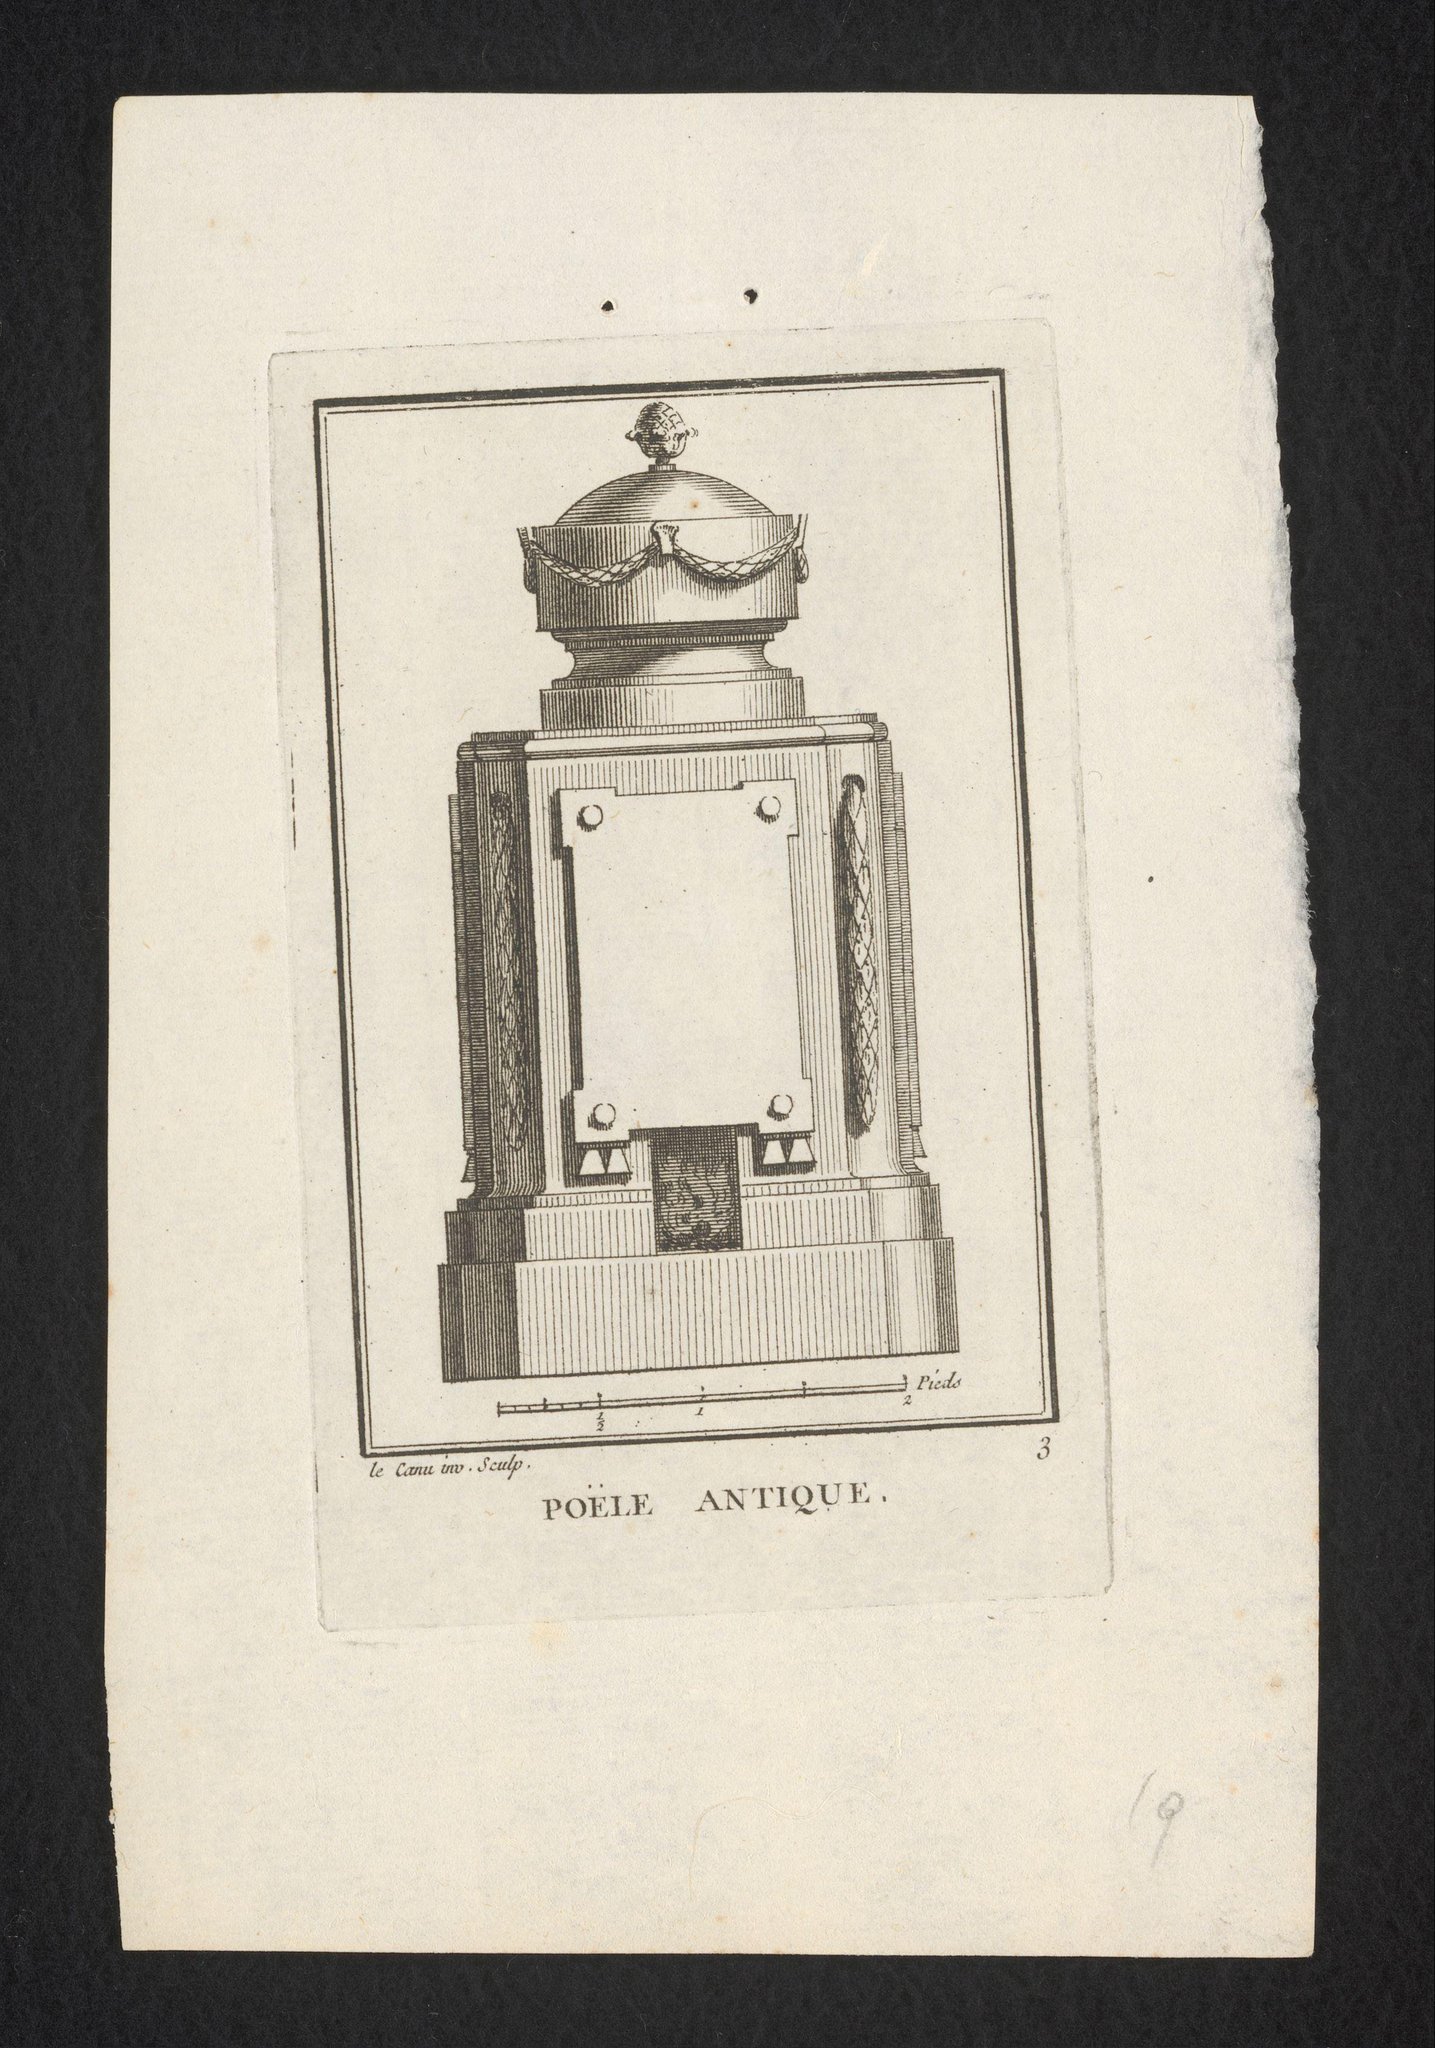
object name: print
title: Poële Antique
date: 1778-1782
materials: paper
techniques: etching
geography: paris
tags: vase ~ ornament, hearth and stove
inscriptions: collector's mark: Lugt 2228, collector's mark: Lugt 2760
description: Ontwerp voor een haard of kachel met een rechthoekig tablet en een vaas met guirlandes en een dennenappel aan de bovenzijde.